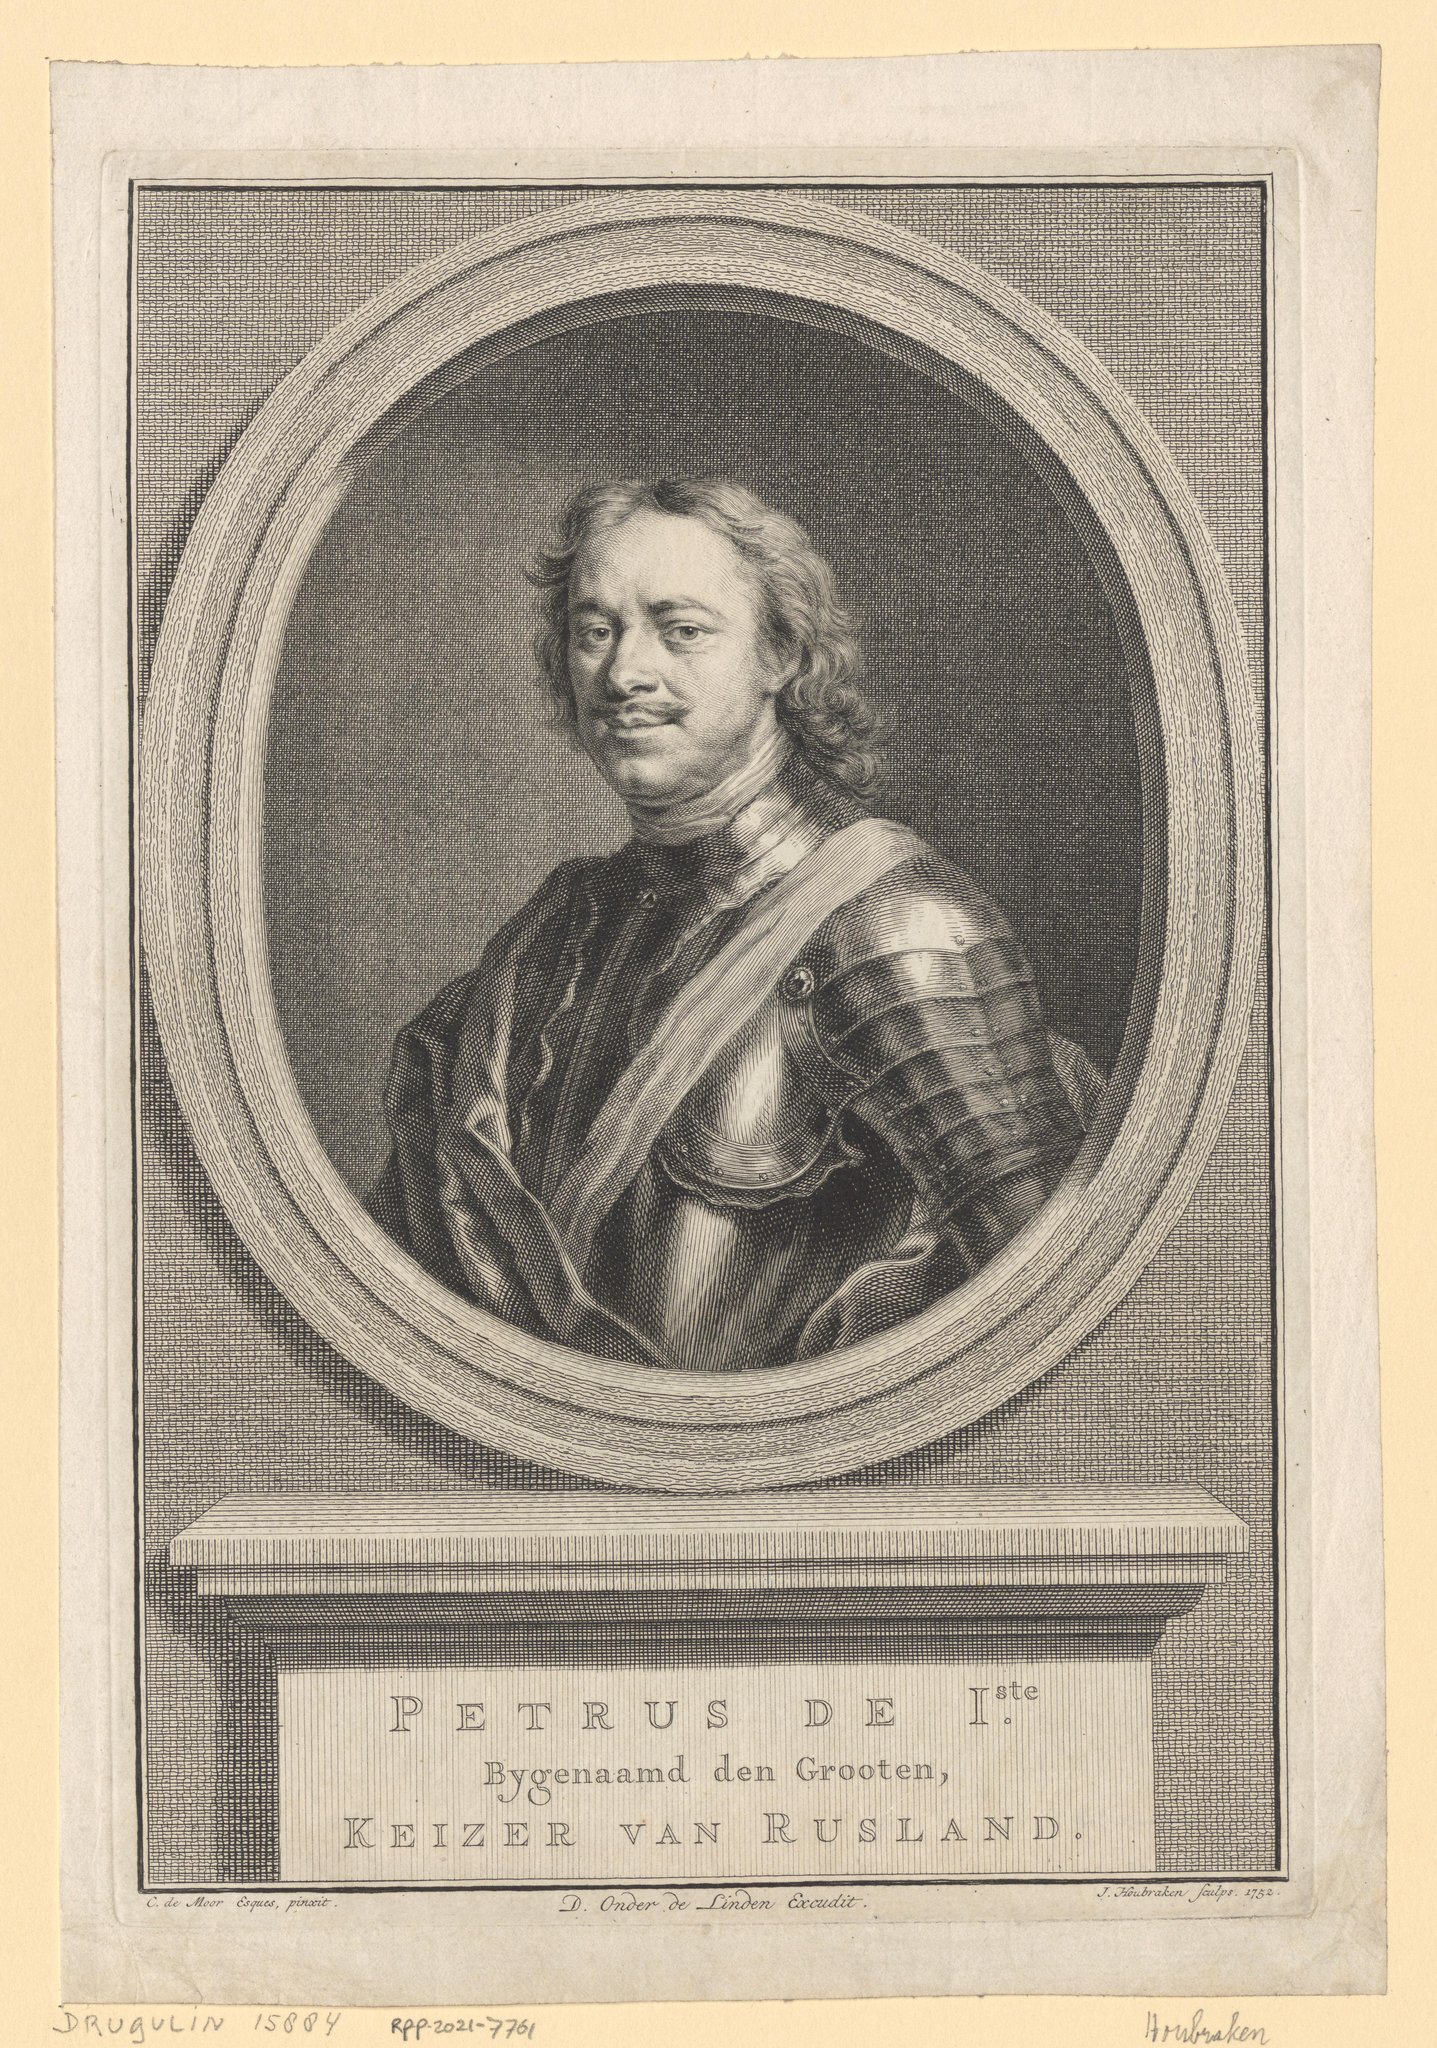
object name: print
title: Portret van Peter I de Grote, tsaar van Rusland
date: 1752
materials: paper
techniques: engraving, etching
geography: amsterdam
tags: peter i de grote (tsaar van rusland), armour, adult man, historical persons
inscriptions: date